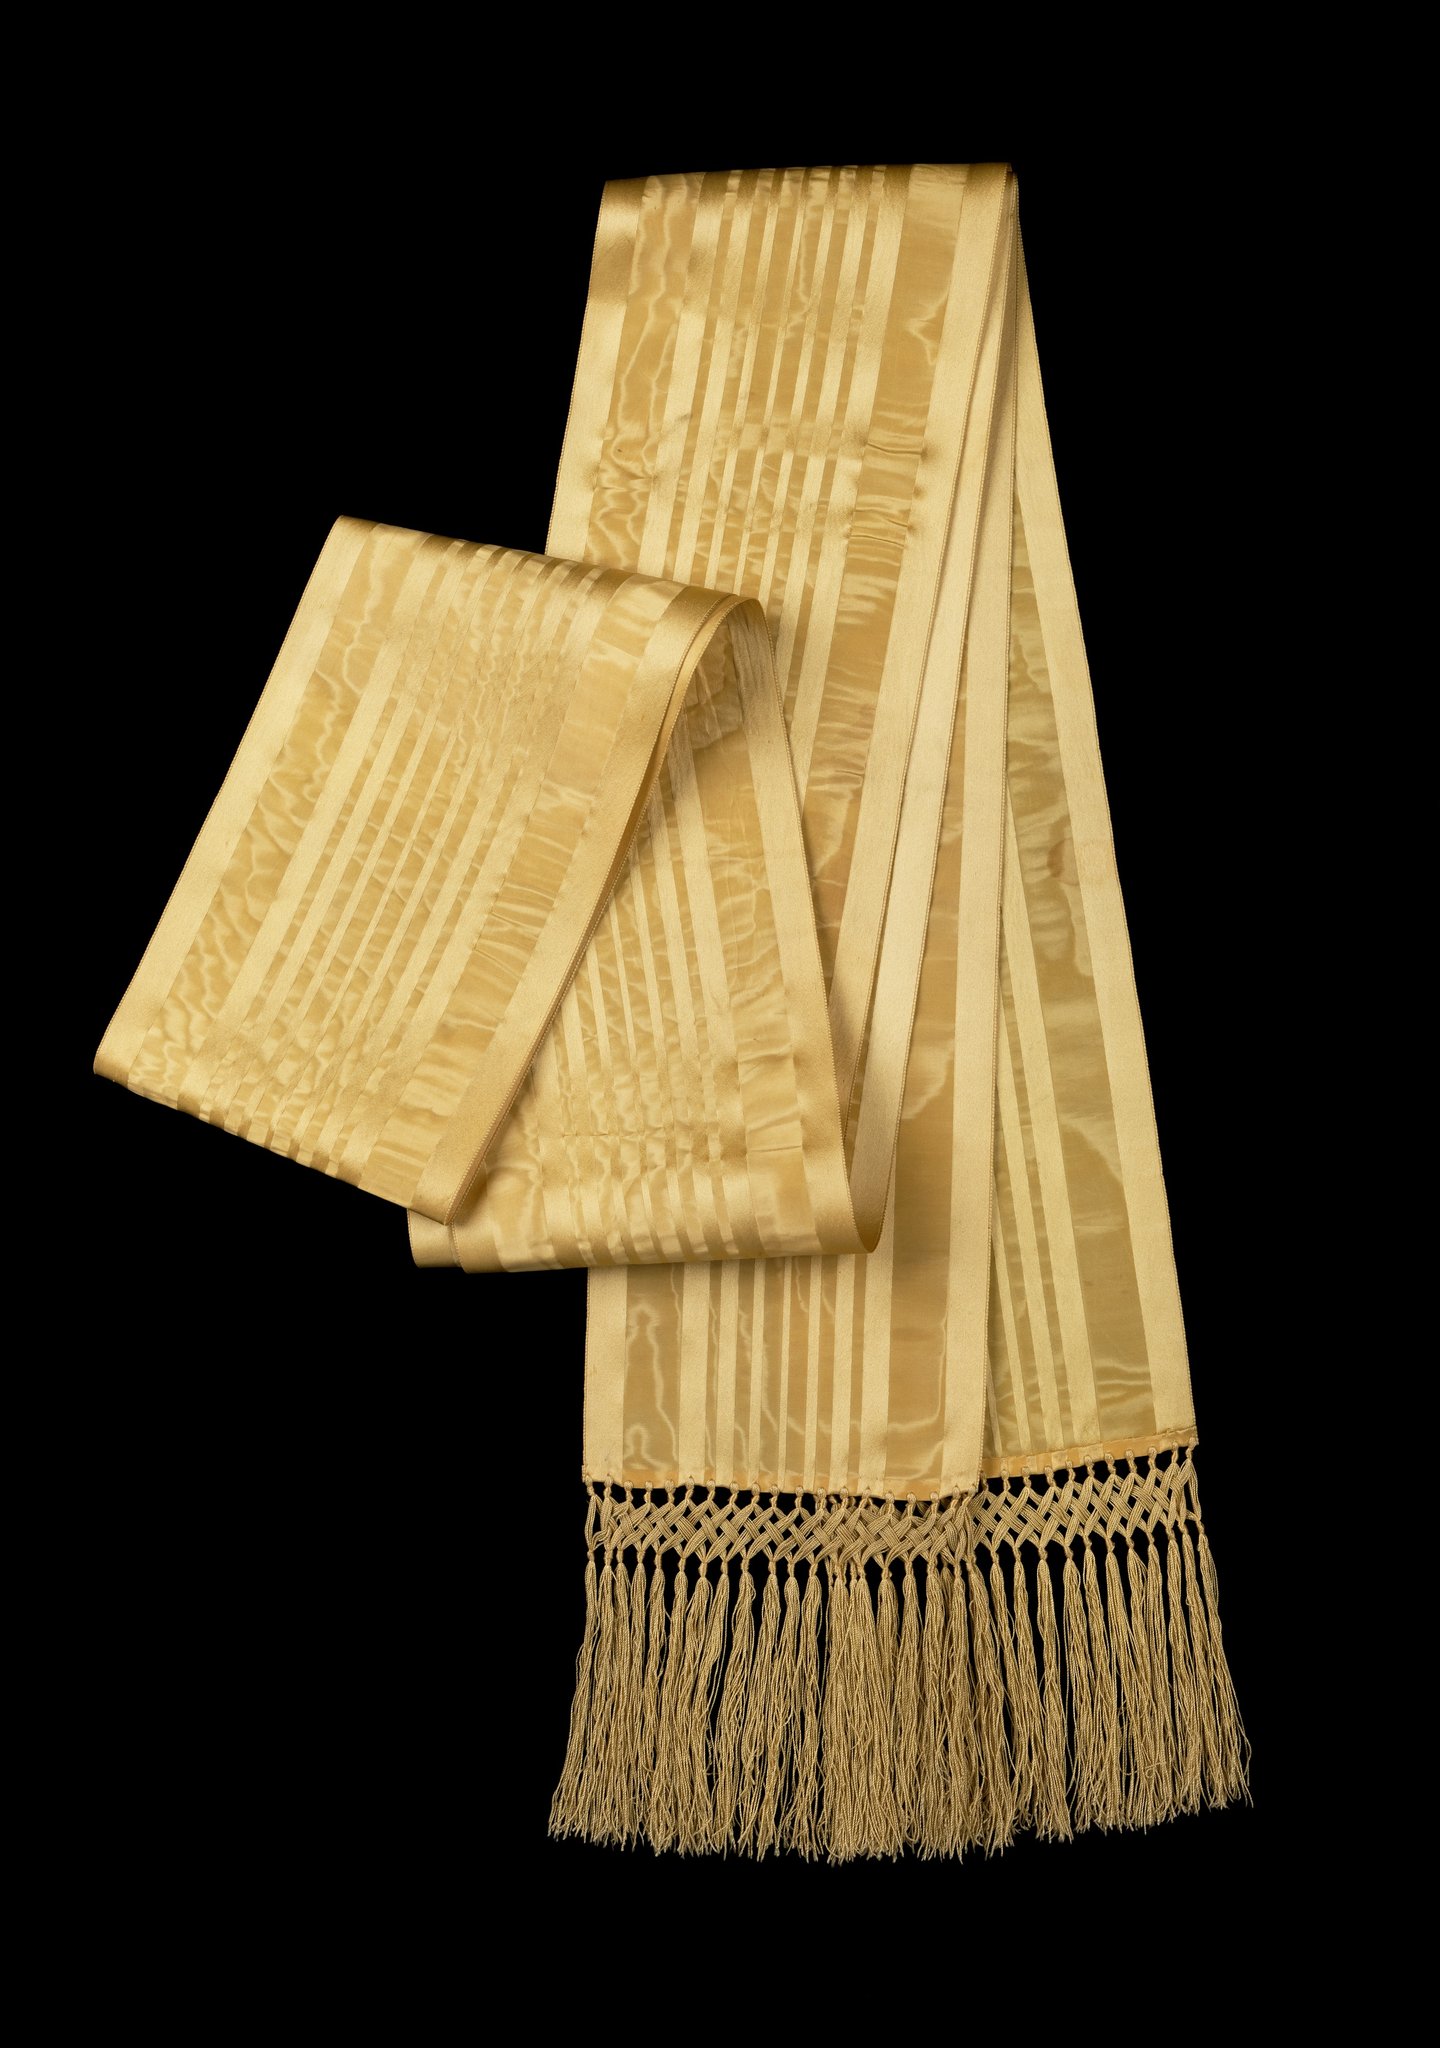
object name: evening sash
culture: french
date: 1876-1900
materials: silk